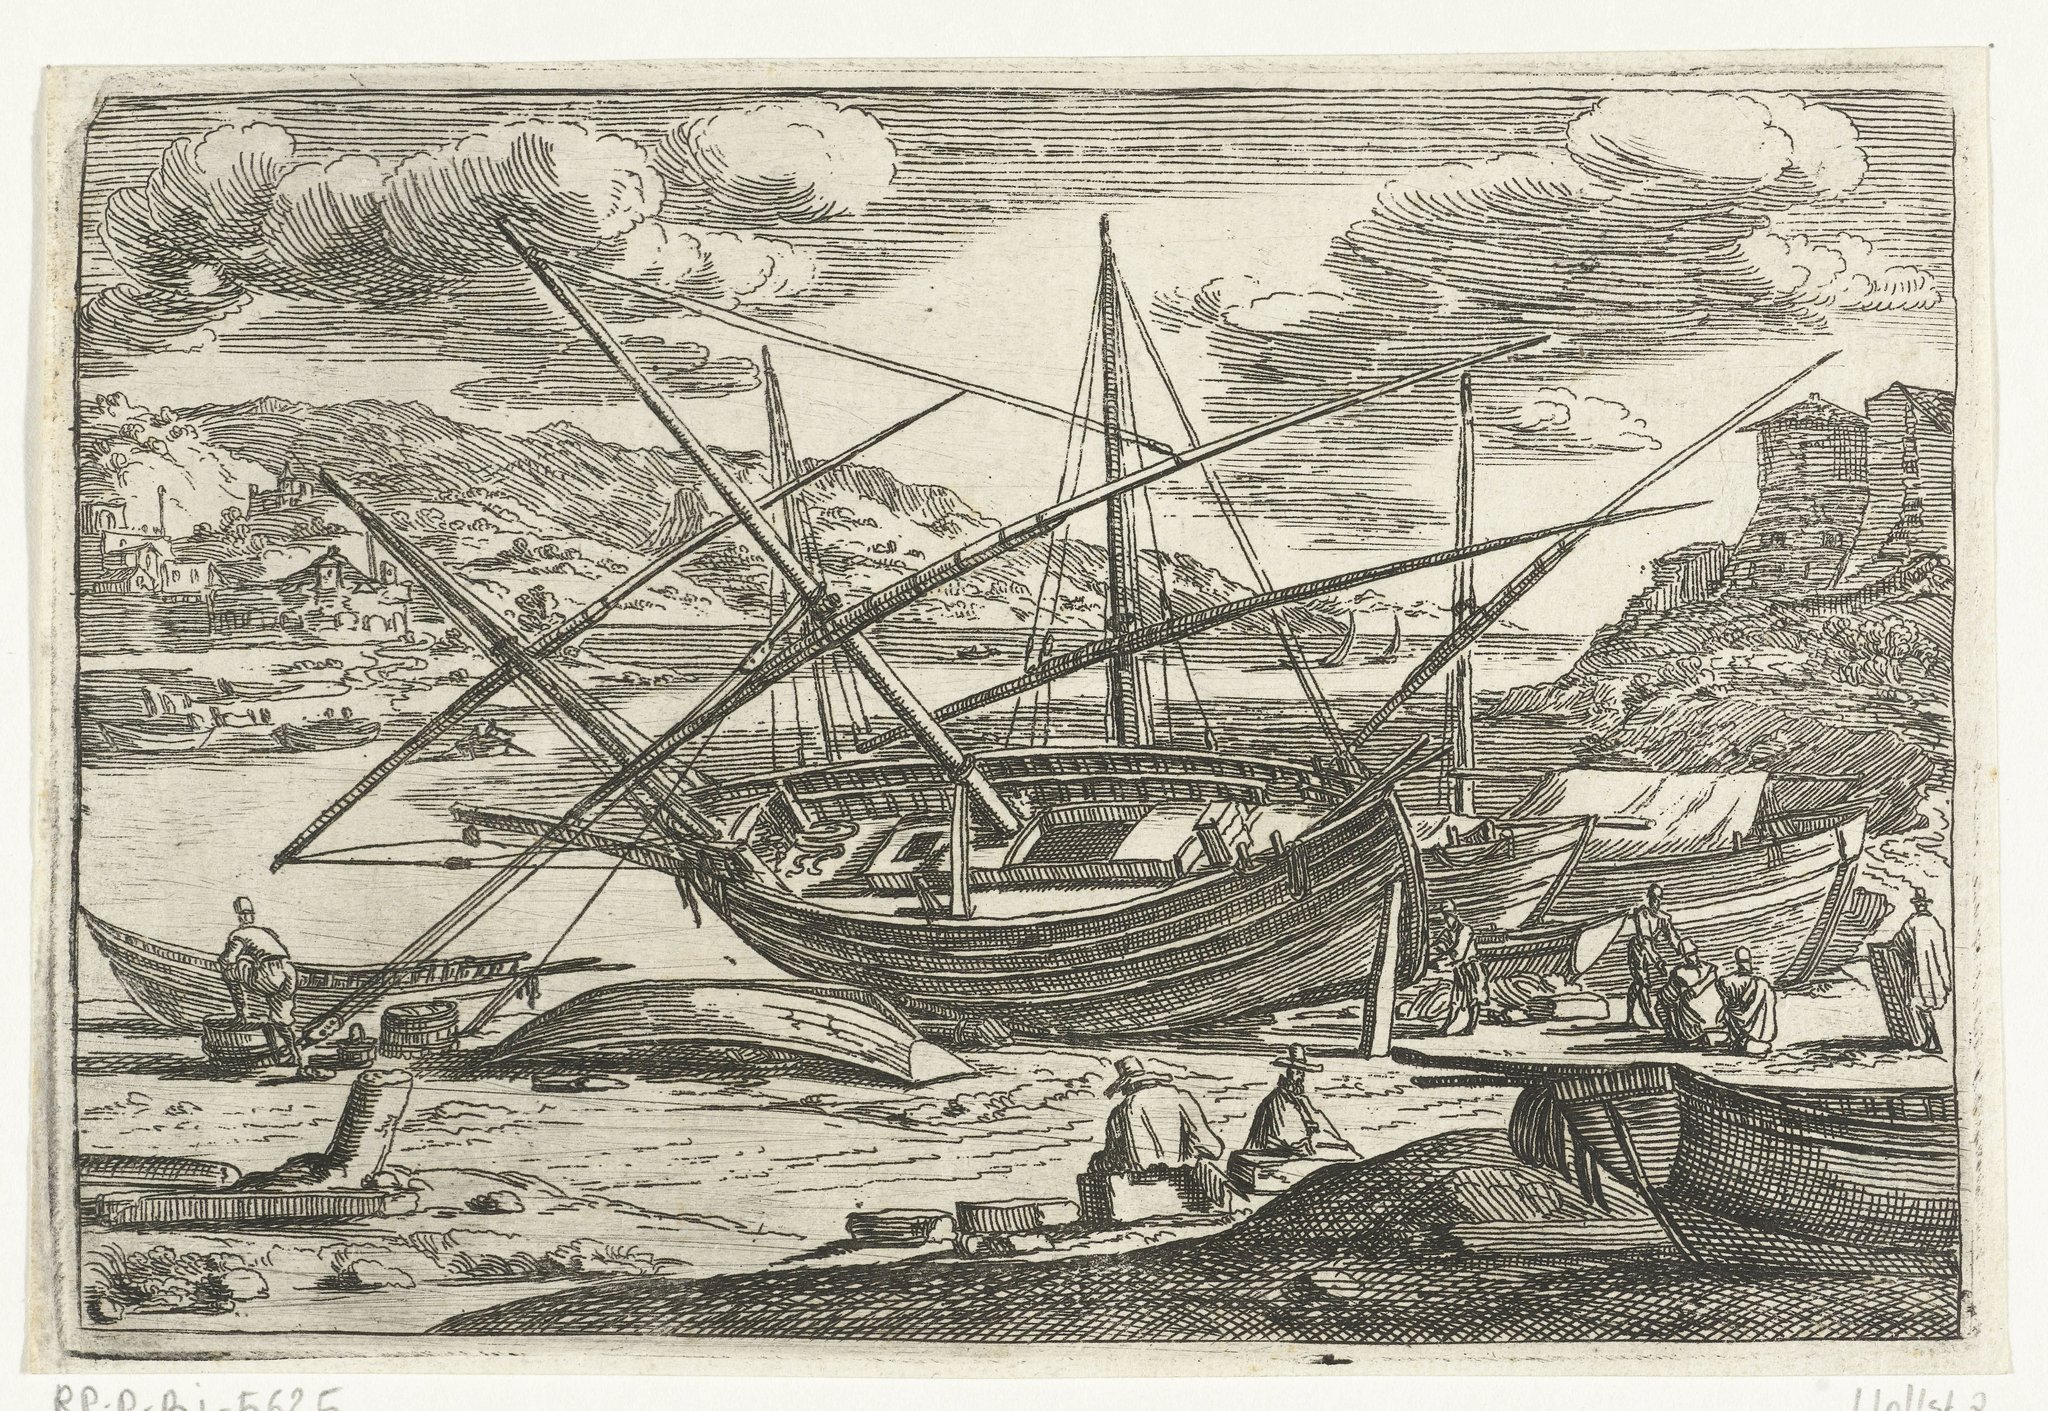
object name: print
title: Reparatie van een vissersboot bij de haven van Messina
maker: abraham de casembroot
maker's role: draughtsman, print maker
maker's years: 1573-1658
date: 1603-1658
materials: paper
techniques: etching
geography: southern netherlands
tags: harbour, sailing-ship, sailing-boat, repairing, caulking, careening (~ ship), quay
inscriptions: collector's mark: Lugt 2166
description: Gezicht op een deel van de haven van Messina. Op de voorgrond ligt het strand waar een vissersboot ligt. Enkele timmerlieden repareren de romp van het schip. Prent uit serie van dertien prenten met gezichten van de haven van Messina